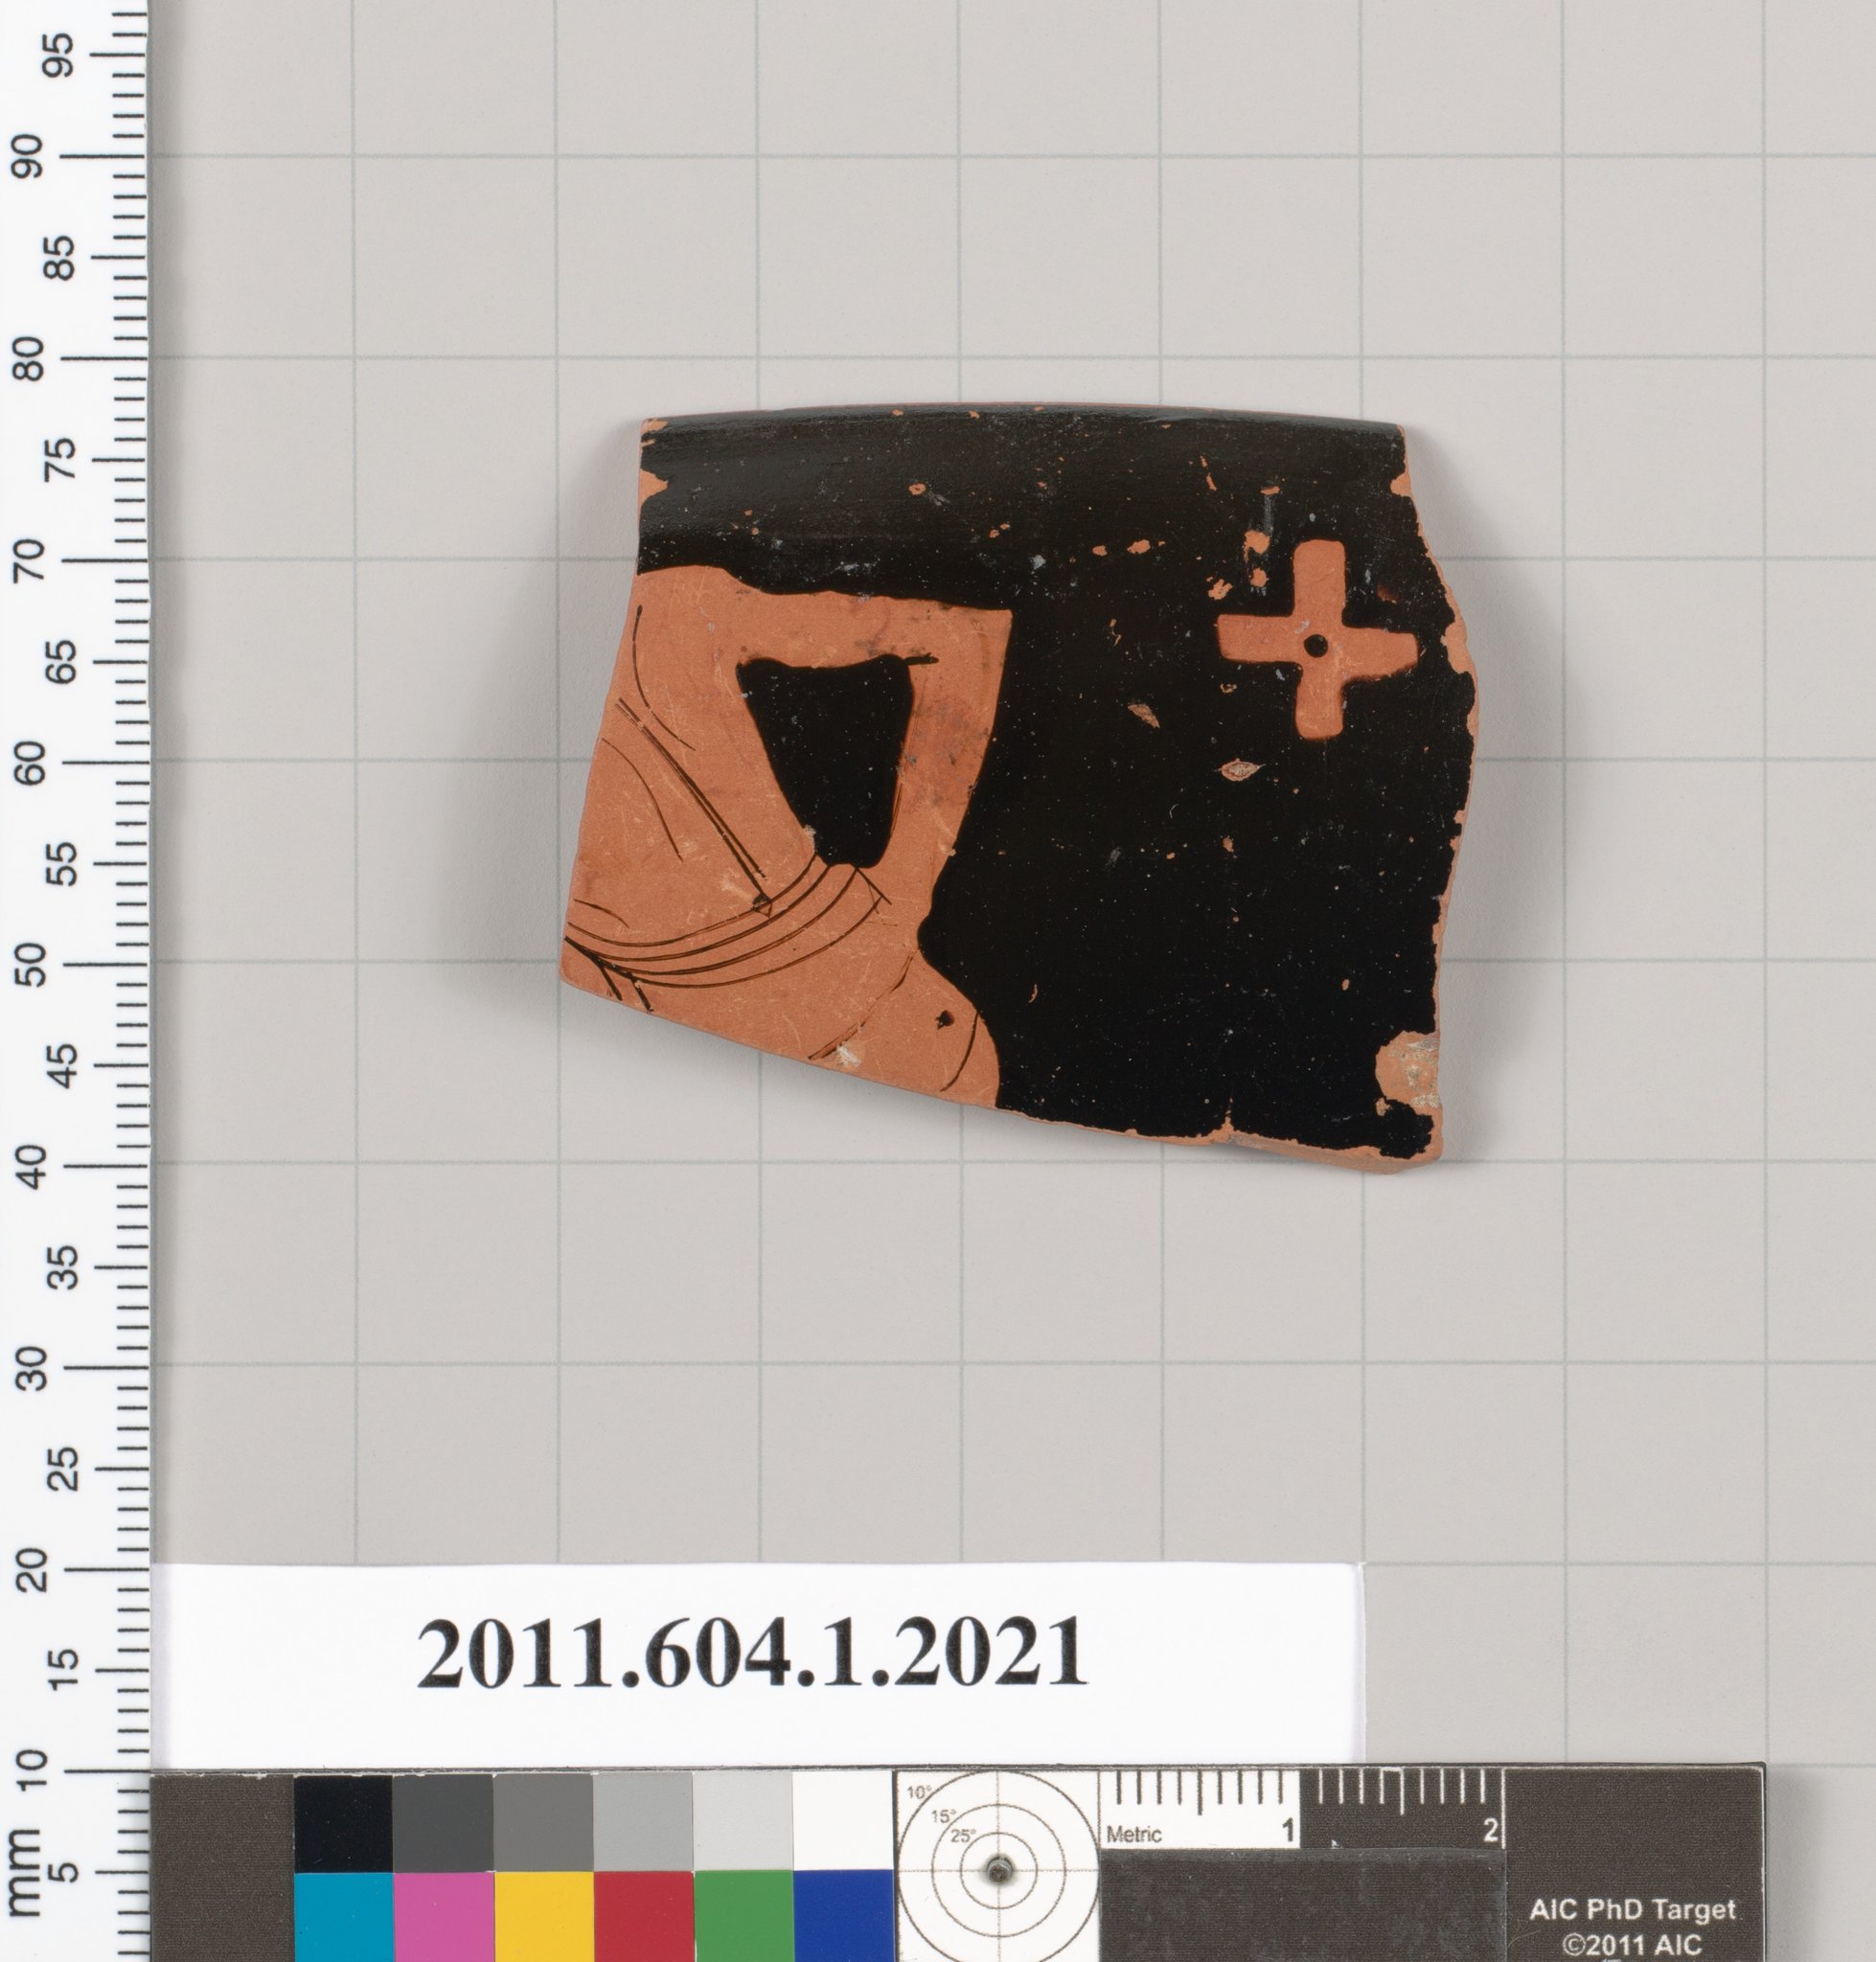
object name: kylix fragment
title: Terracotta rim fragment of a kylix (drinking cup)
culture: greek, attic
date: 475-451 BCE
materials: terracotta